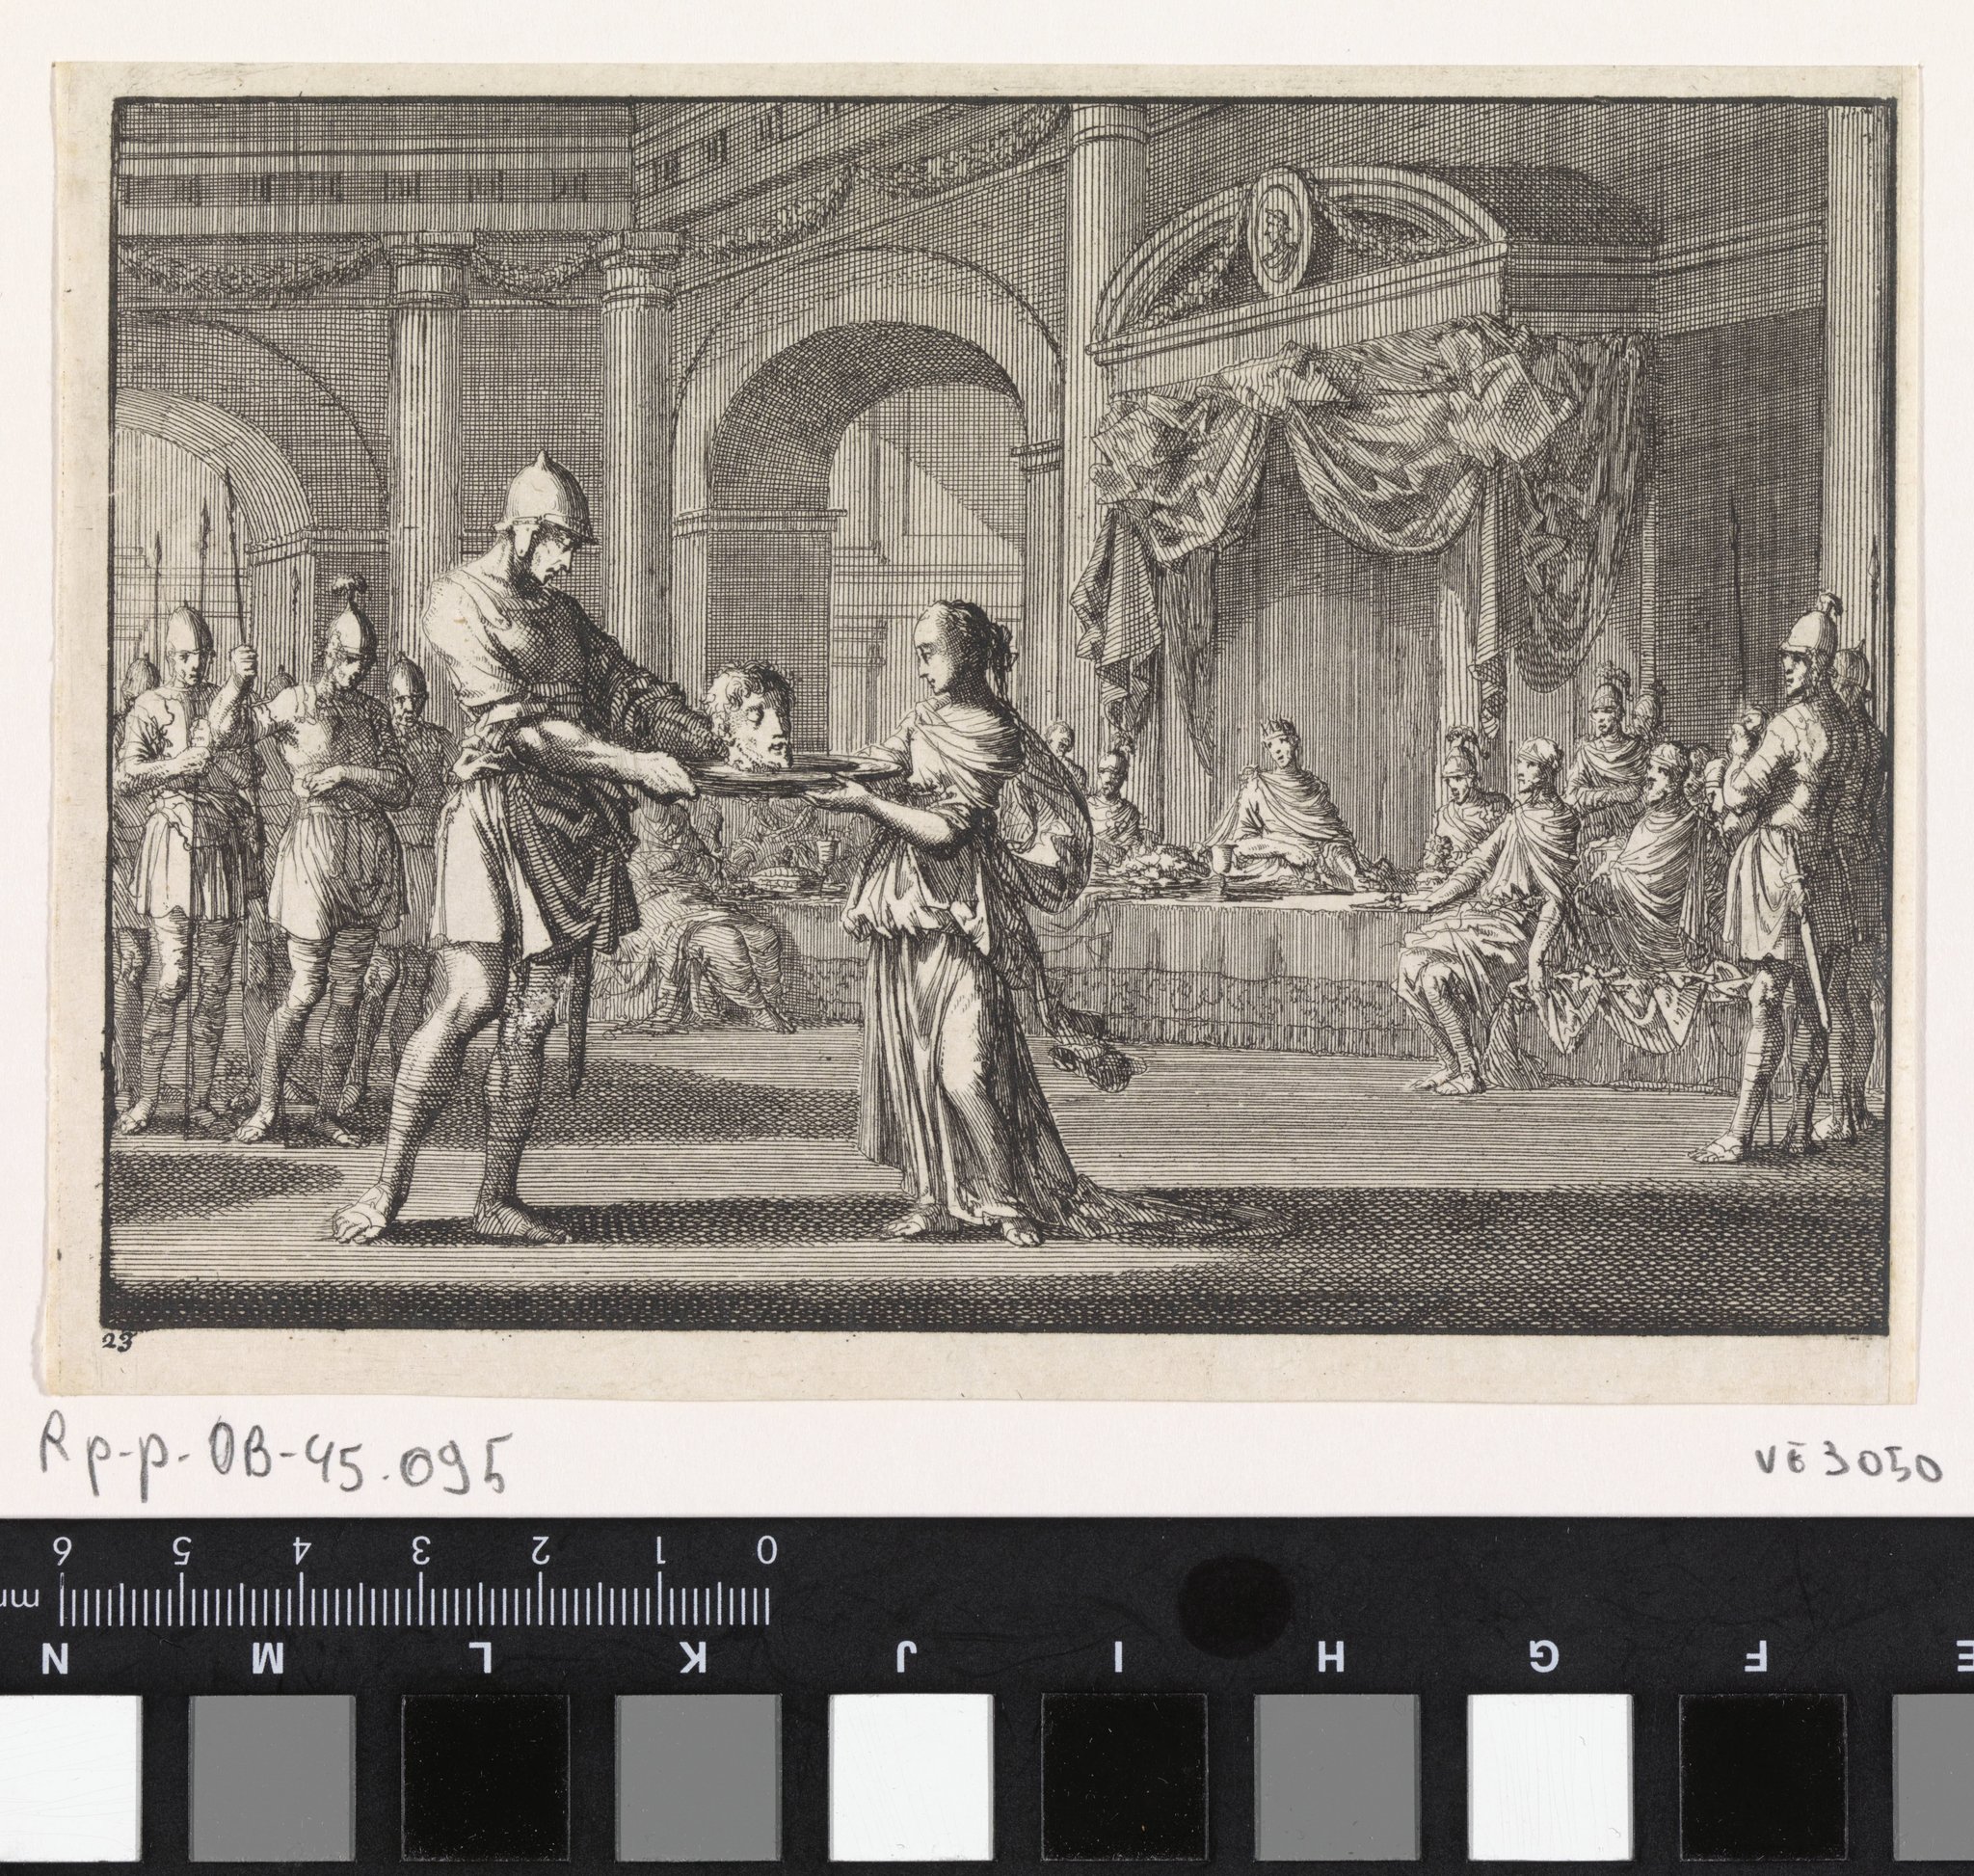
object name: print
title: Salome ontvangt het hoofd van Johannes de Doper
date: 1703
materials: paper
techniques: etching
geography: amsterdam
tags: salome is given the head of john the baptist by the executioner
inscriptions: collector's mark: Lugt 2228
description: Proefdruk van een boekillustratie voor David Martin. Historie des Ouden en Nieuwen Testaments. Amsterdam, Pieter Mortier, 1703. Deel II. De boekillustraties voor de Mortierbijbel hebben verschillende staten en kopieën, waarbij de chronologische volgorde moeilijk te achterhalen valt. Als boekillustraties werden ze bovendien herhaaldelijk opnieuw gebruikt voor andere boekwerken.